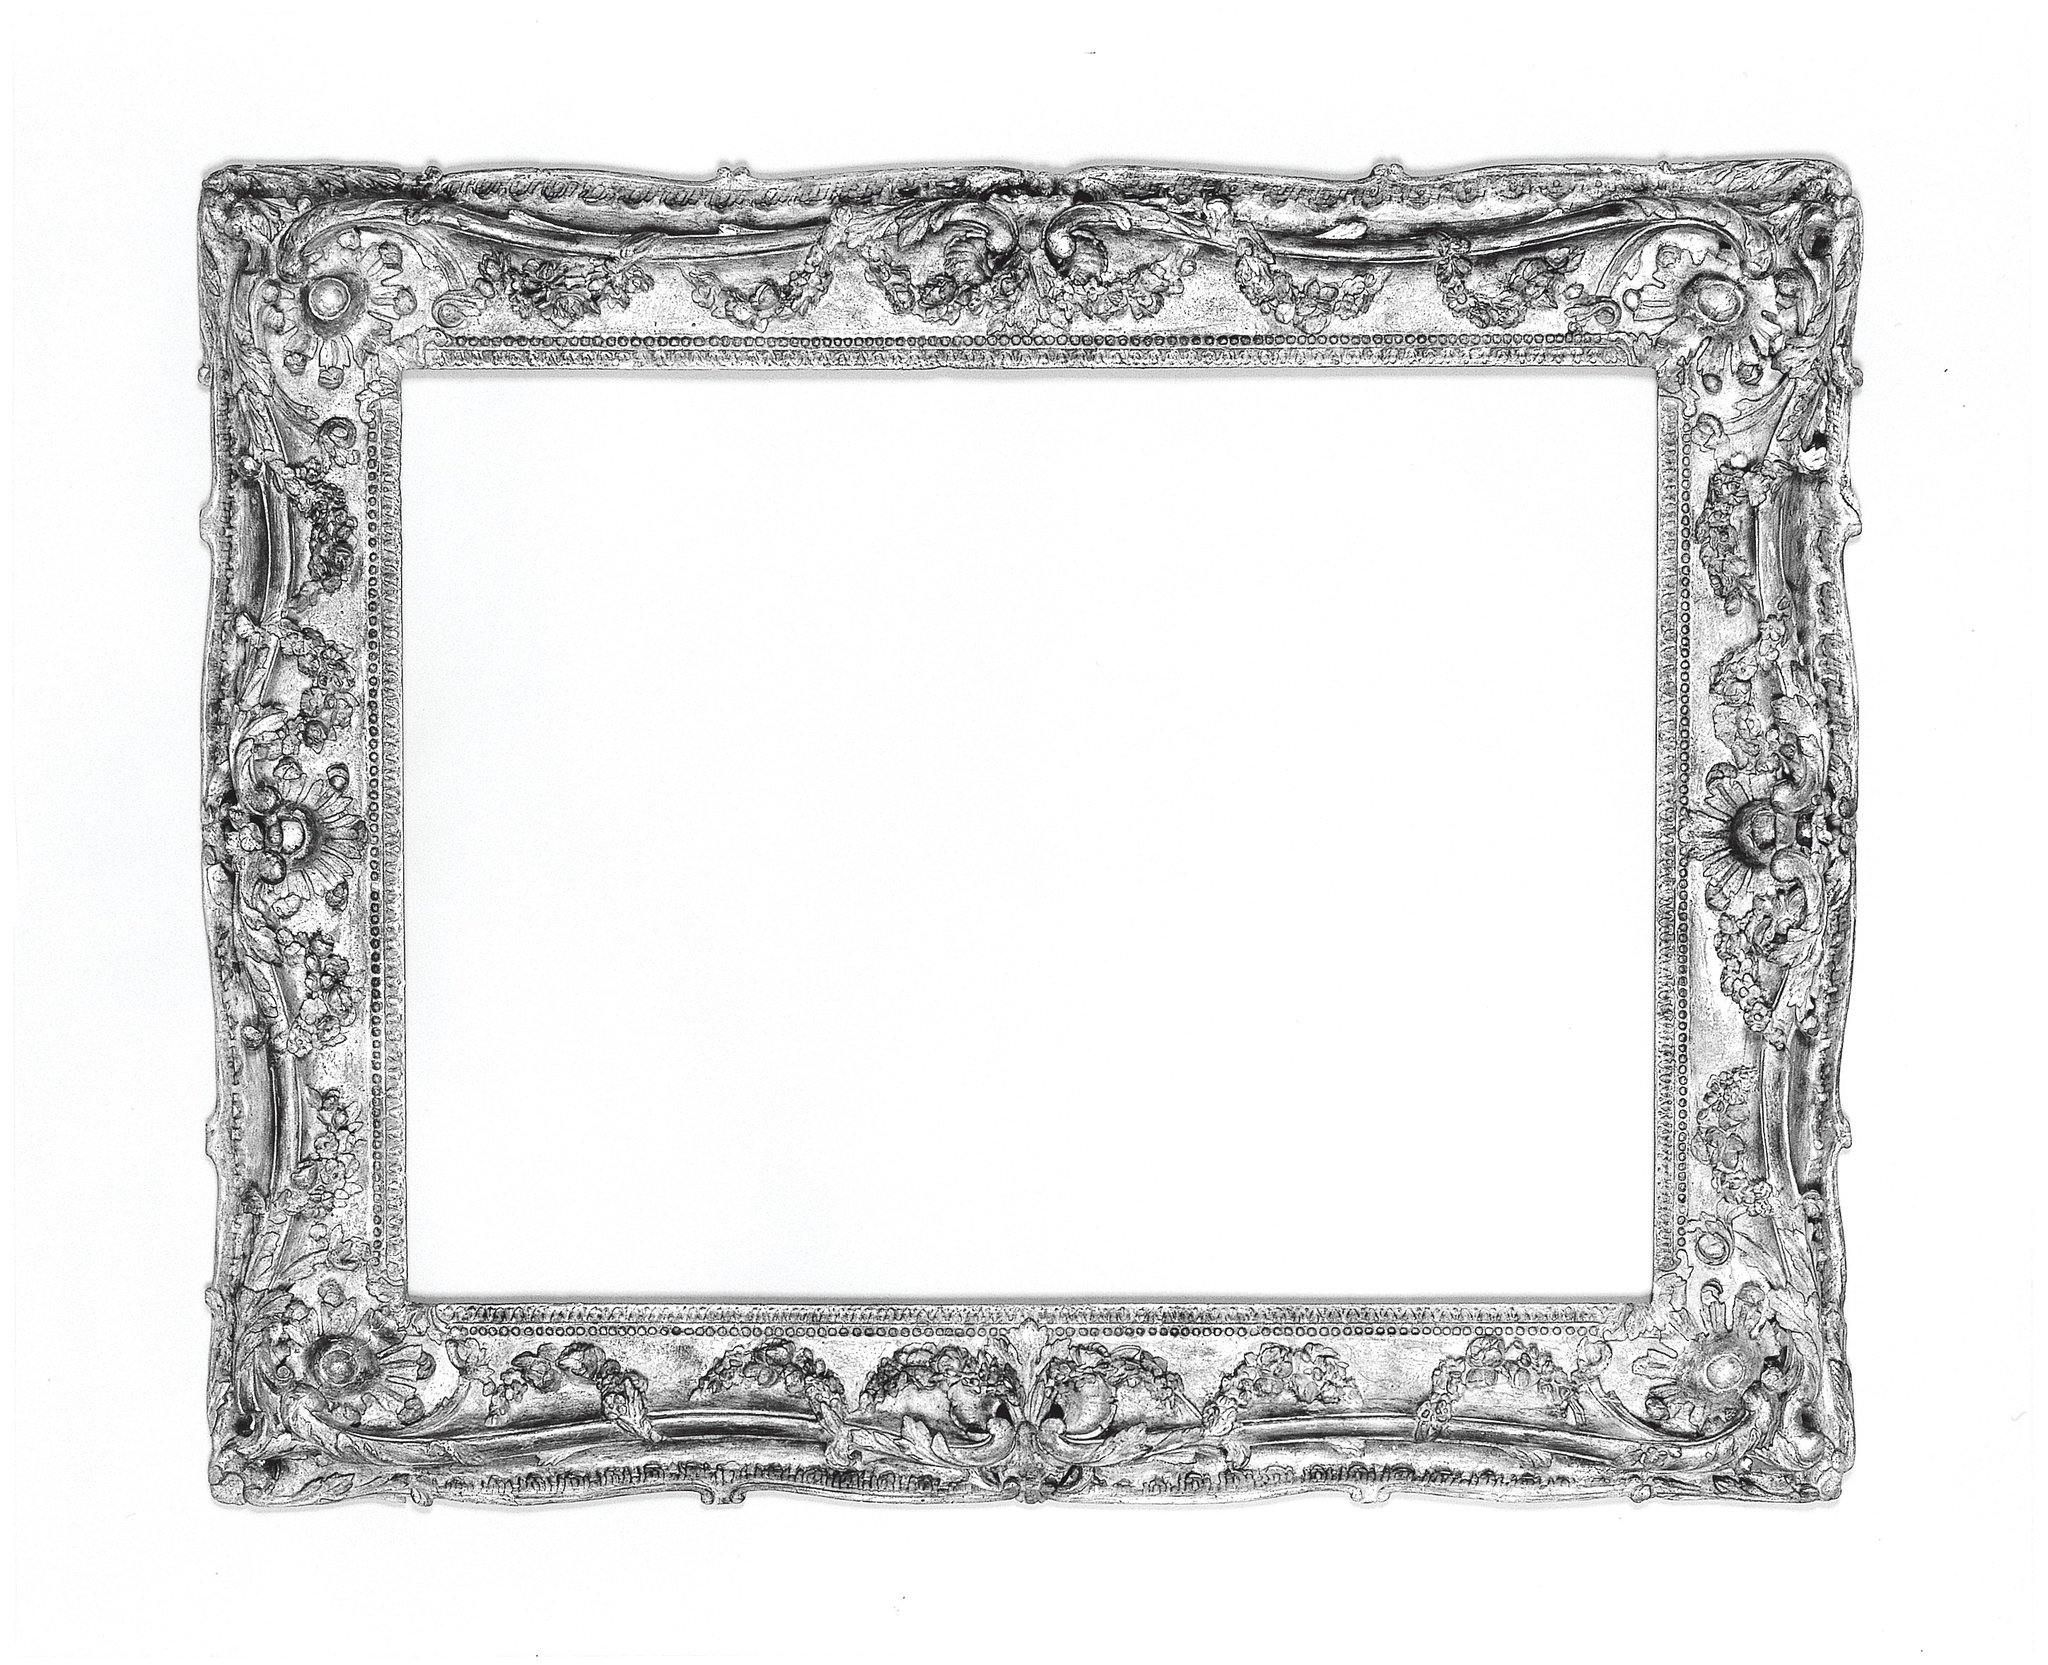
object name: frame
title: Swept frame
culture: french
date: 1760-1765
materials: feather, wood